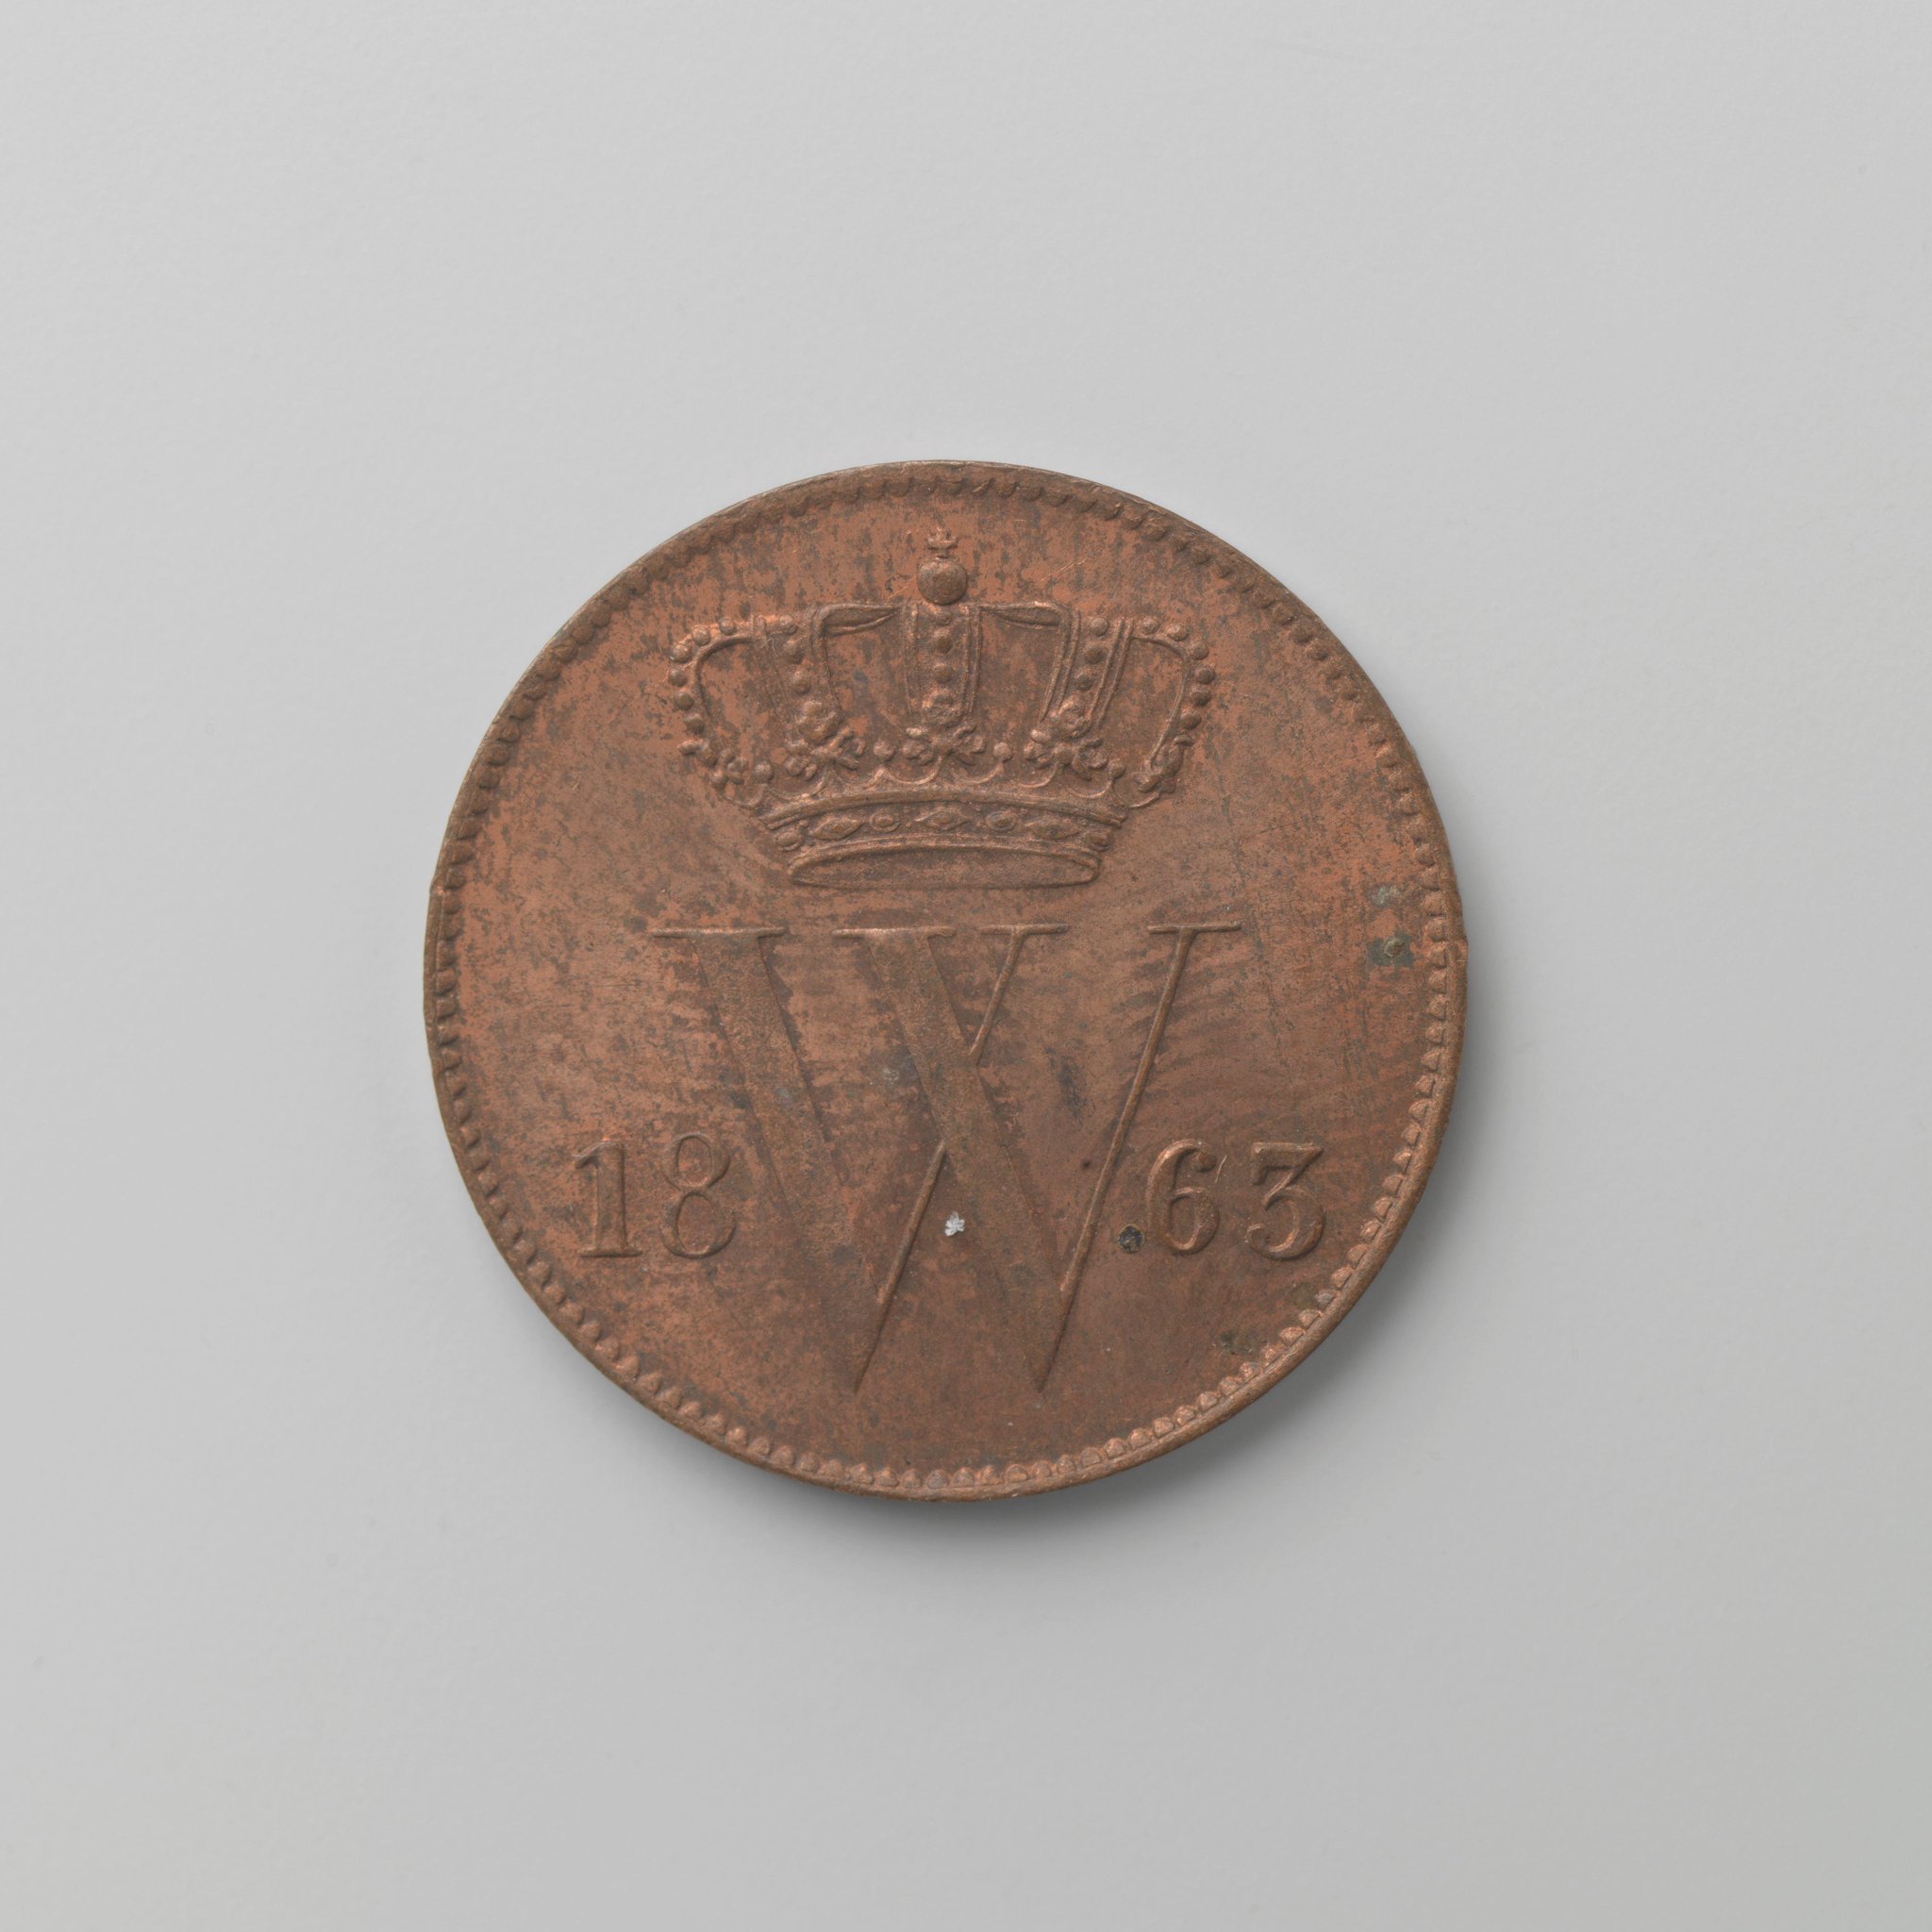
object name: coin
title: Nederlandse cent, 1863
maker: willem iii (koning der nederlanden)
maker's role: koning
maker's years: 1817-1890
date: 1863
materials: copper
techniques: striking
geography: utrecht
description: Koperen munt. Voorzijde: tussen jaartal gekroonde rechte letter W. Keerzijde: tussen waarde-aanduiding 1 C. gekroond rijkswapenschild. Gladde rand.